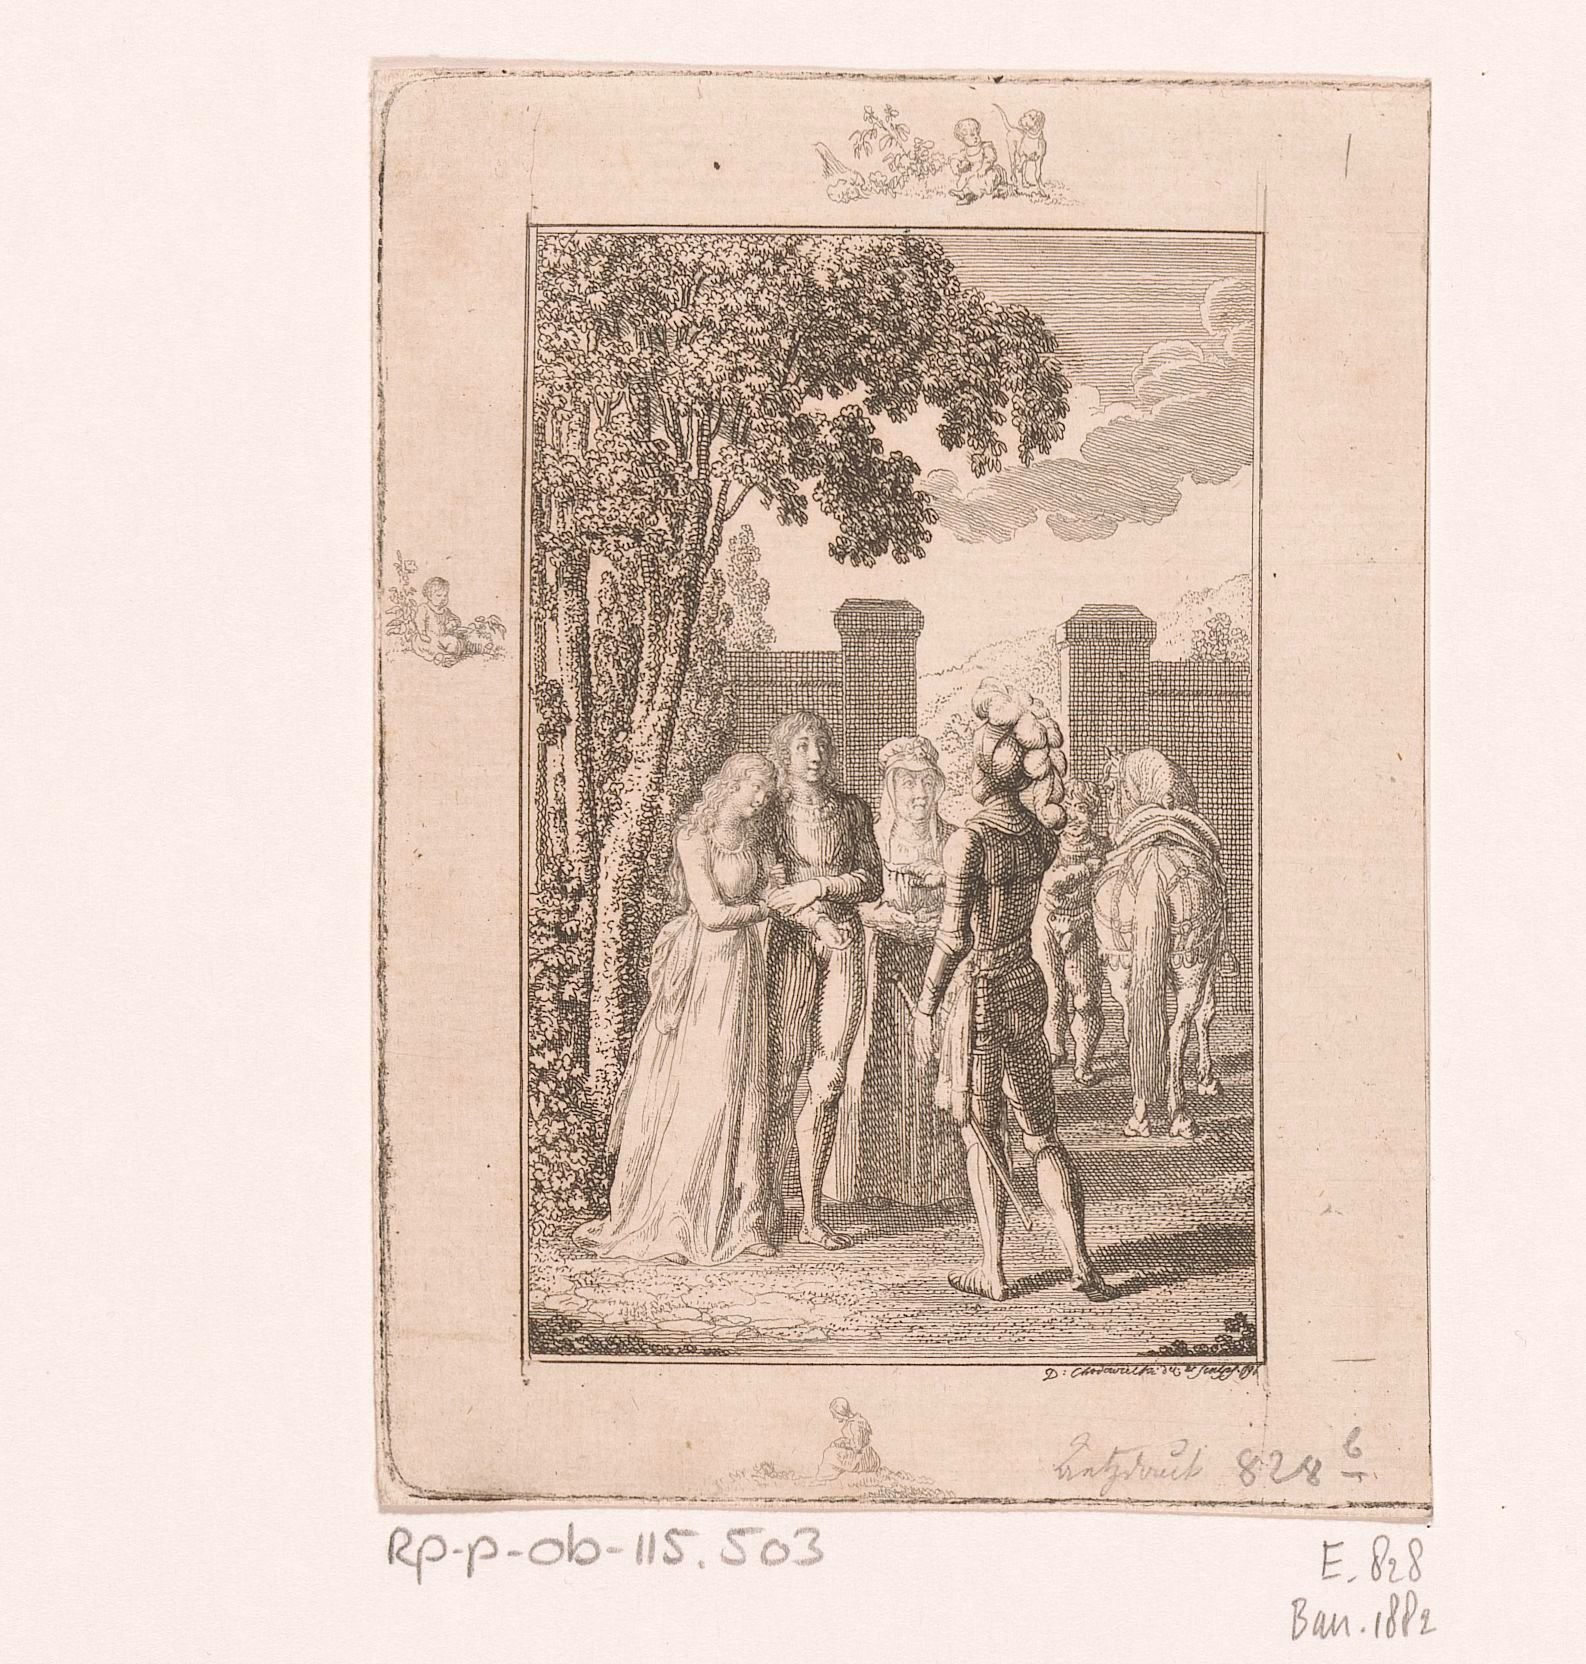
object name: print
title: Ludwig vraagt Egbert wat hij tegen Bertha moet zeggen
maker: daniel nikolaus chodowiecki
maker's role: draughtsman, print maker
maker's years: 1726-1801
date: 1796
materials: paper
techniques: etching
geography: berlin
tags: literature, betrothal, knight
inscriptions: collector's mark: Lugt 2228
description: Latere staat gebruikt voor: Becker, Wilhelm Gottlieb. Taschenbuch und Almanach zum geselligen Vergnügen, von W. G. Becker für 1797. Leipzig: Voss und Comp., [1796].